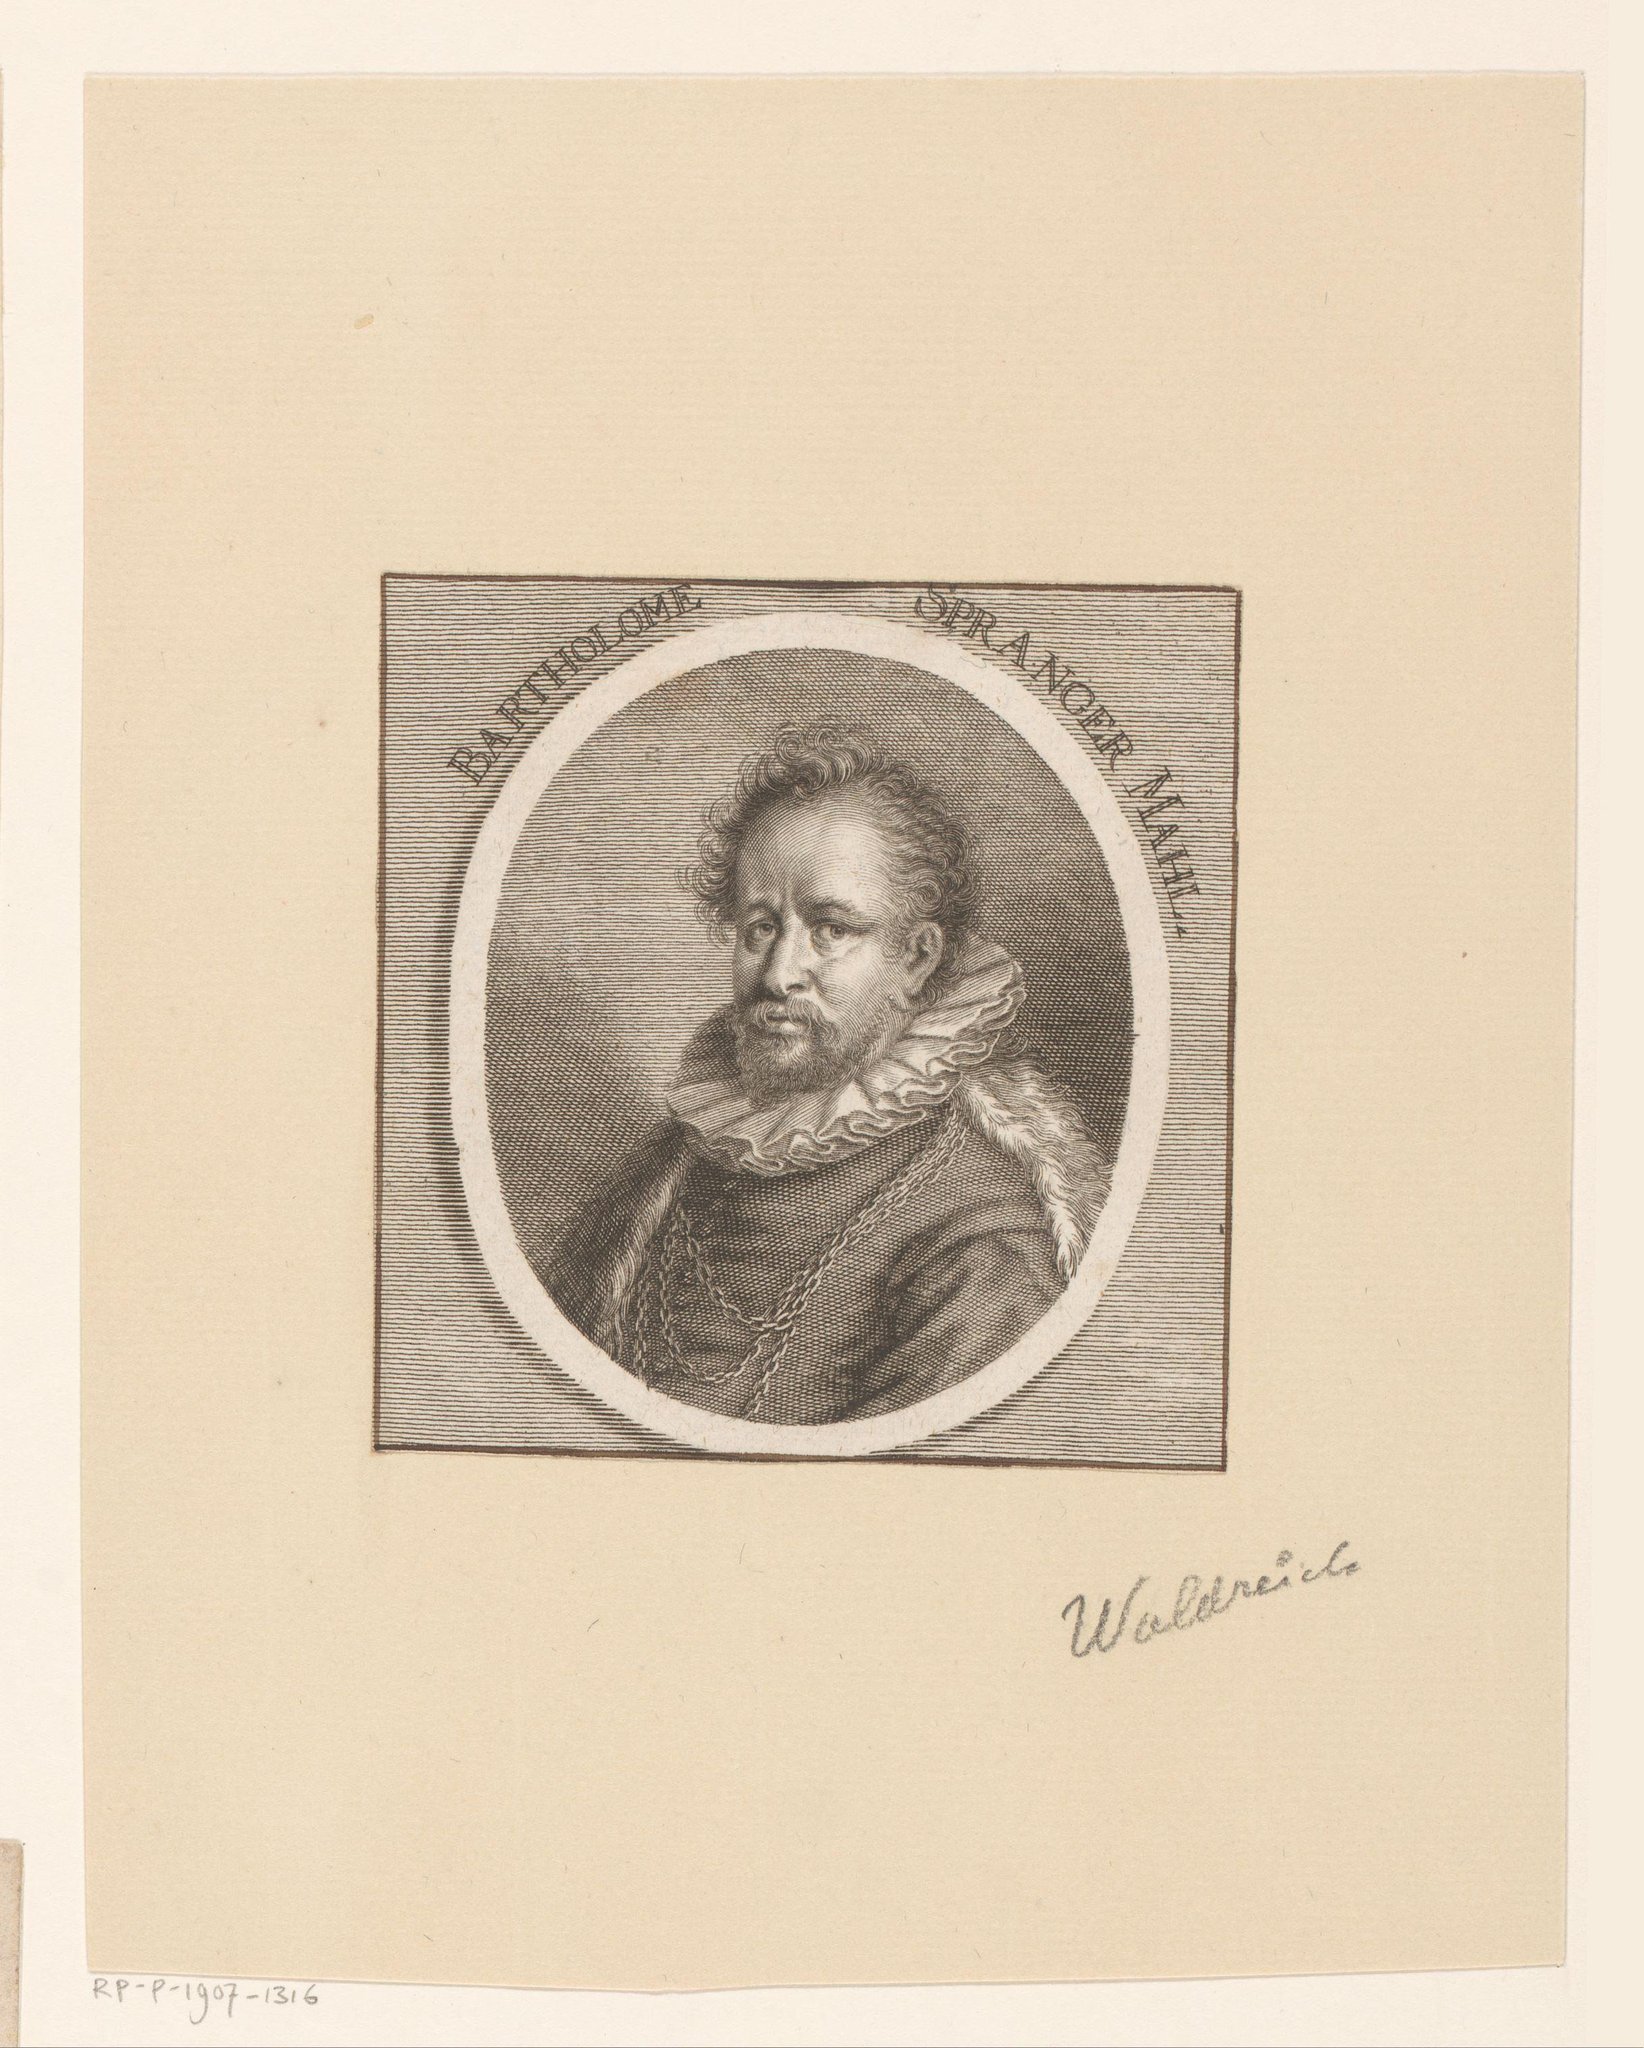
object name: print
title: Portret van Bartholomeus Spranger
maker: johann georg waldreich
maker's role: print maker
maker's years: -1680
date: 1675-1680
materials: paper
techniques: engraving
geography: nuremberg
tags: prague, painter, bartholomeus spranger, historical persons, portrait, self-portrait of artist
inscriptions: collector's mark: Lugt 2228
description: Fragment van een prent gebruikt voor: Sandrart, Joachim von. L'Academia Todesca della Architectura Scultura e Pittura oder Teutsche Academie der Edlen Bau-, Bild- und Mahlerey-Künste. Nürnberg: Neurenberg: 1675-1680. Afkomstig van een blad met zes kunstenaarsportretten, samen met de portretten van Giambologna, Pieter Brueghel I, Joos van Winghe, Hans von Aachen en Joseph Heintz I.